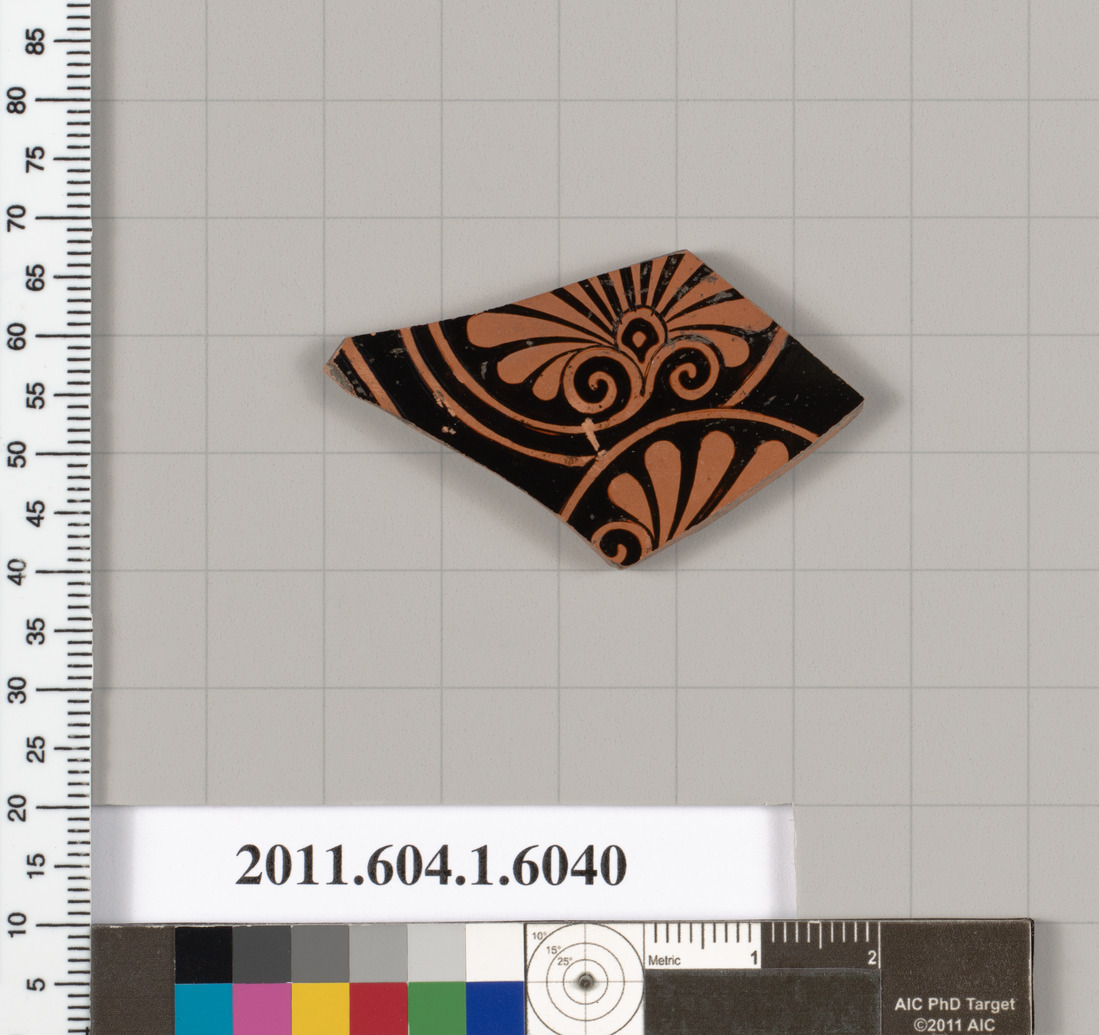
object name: kylix fragment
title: Terracotta fragment of a kylix (drinking cup)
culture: greek, attic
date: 510-500 BCE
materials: terracotta